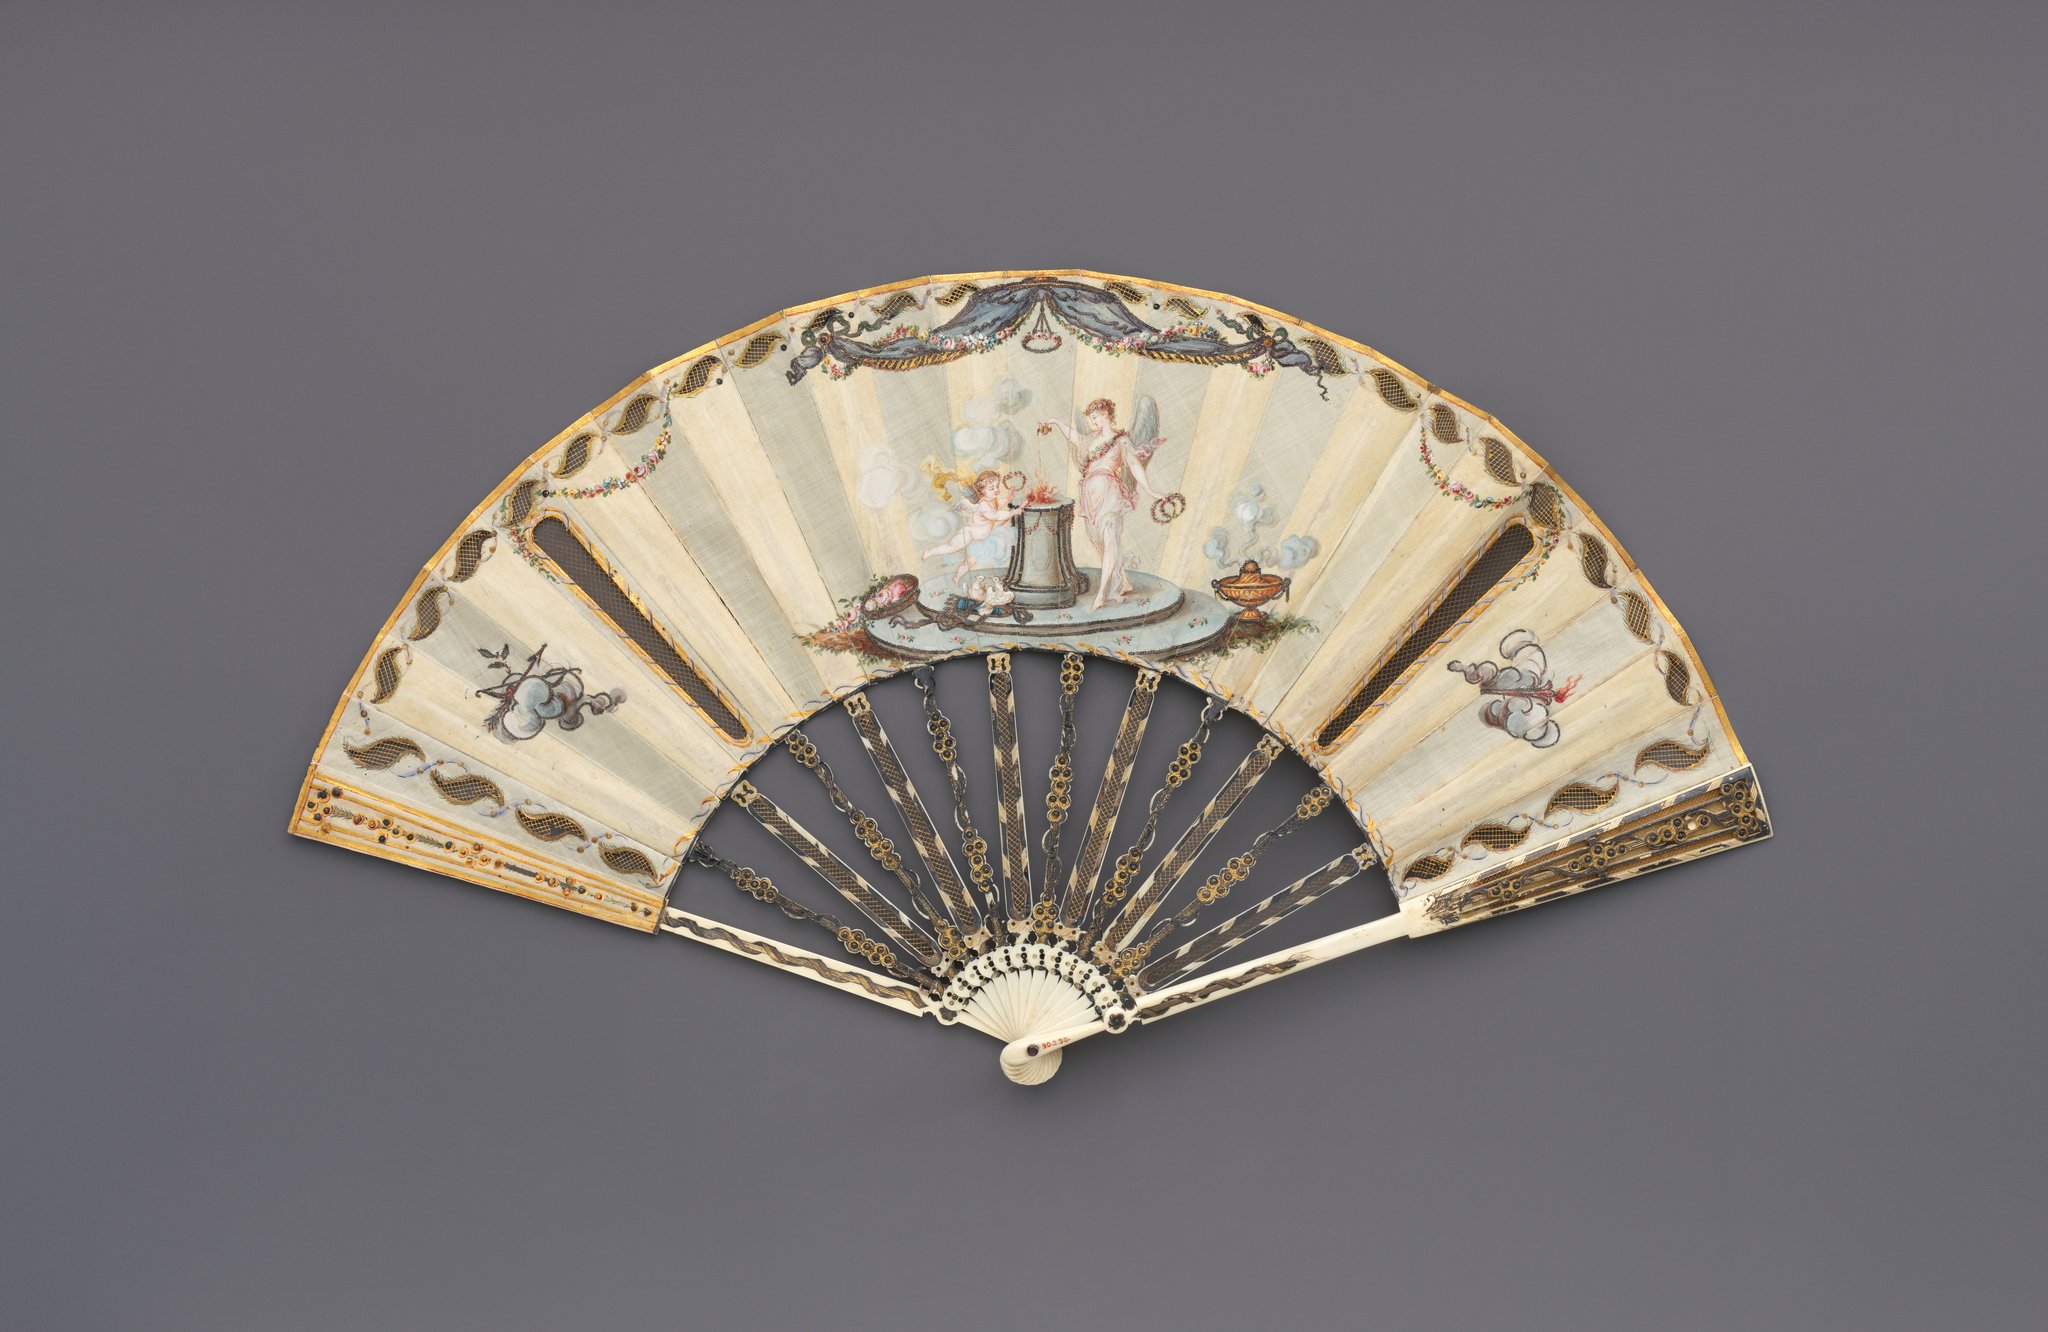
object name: fan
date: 1767-1800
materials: gilt, ivory, paint, silk